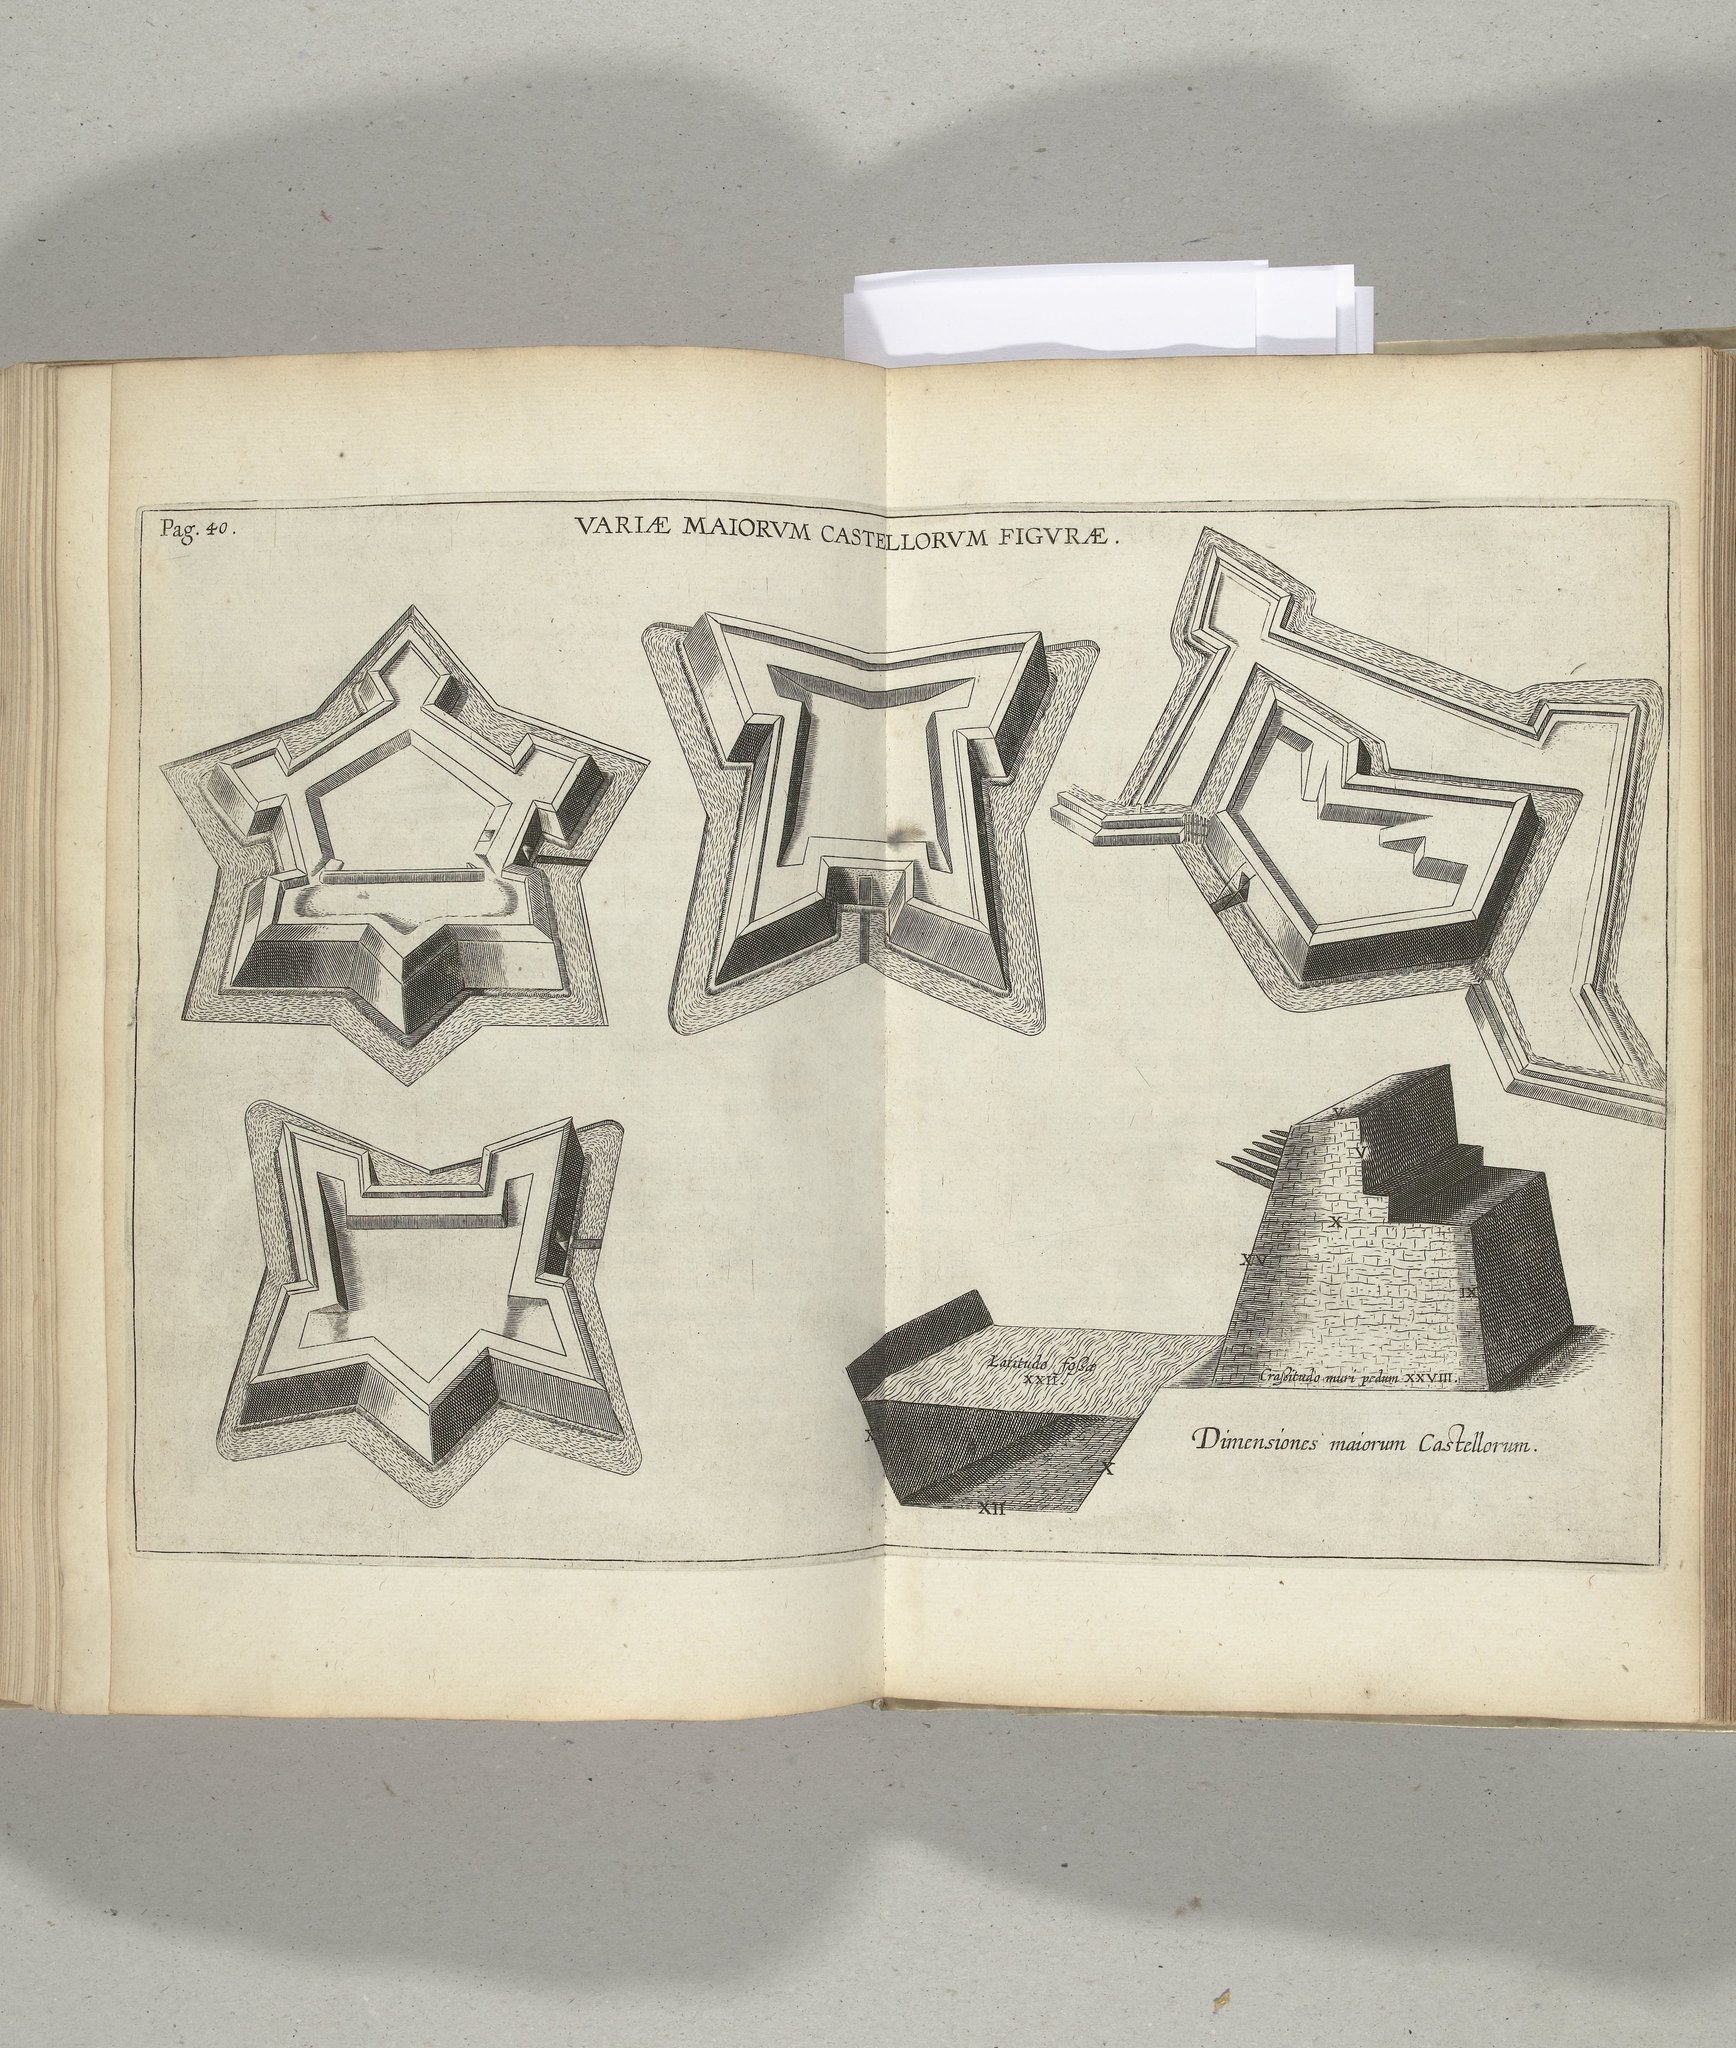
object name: print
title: Verschillende van de belangrijkste typen schansen en vestingen, 1624-1625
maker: Anonymous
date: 1625-1626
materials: paper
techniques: engraving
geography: southern netherlands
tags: fortifications, military engineering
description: Illustratie in: Hermannus Hugo, Obsidio Bredana armis Philippi IIII avspiciis Isabellae Dvctv Ambr. Spinolae perfecta, ex off. Plantiniana, Antwerpen 1629, p. 40/41. Exemplaar in de collectie van de Rijksmuseum Research Library met signatuur 327 I 25. In M. Funck, Le livre belge à gravures : guide de l'amateur de livres illustrés imprimés en Belgique avant le XVIIIe siècle (1925) worden deze illustraties toegeschreven aan Theodoor Galle (11) en Schelte en Boëtius Bolswert (4). Ze worden echter in Hollstein niet bij deze prentmakers vermeld.